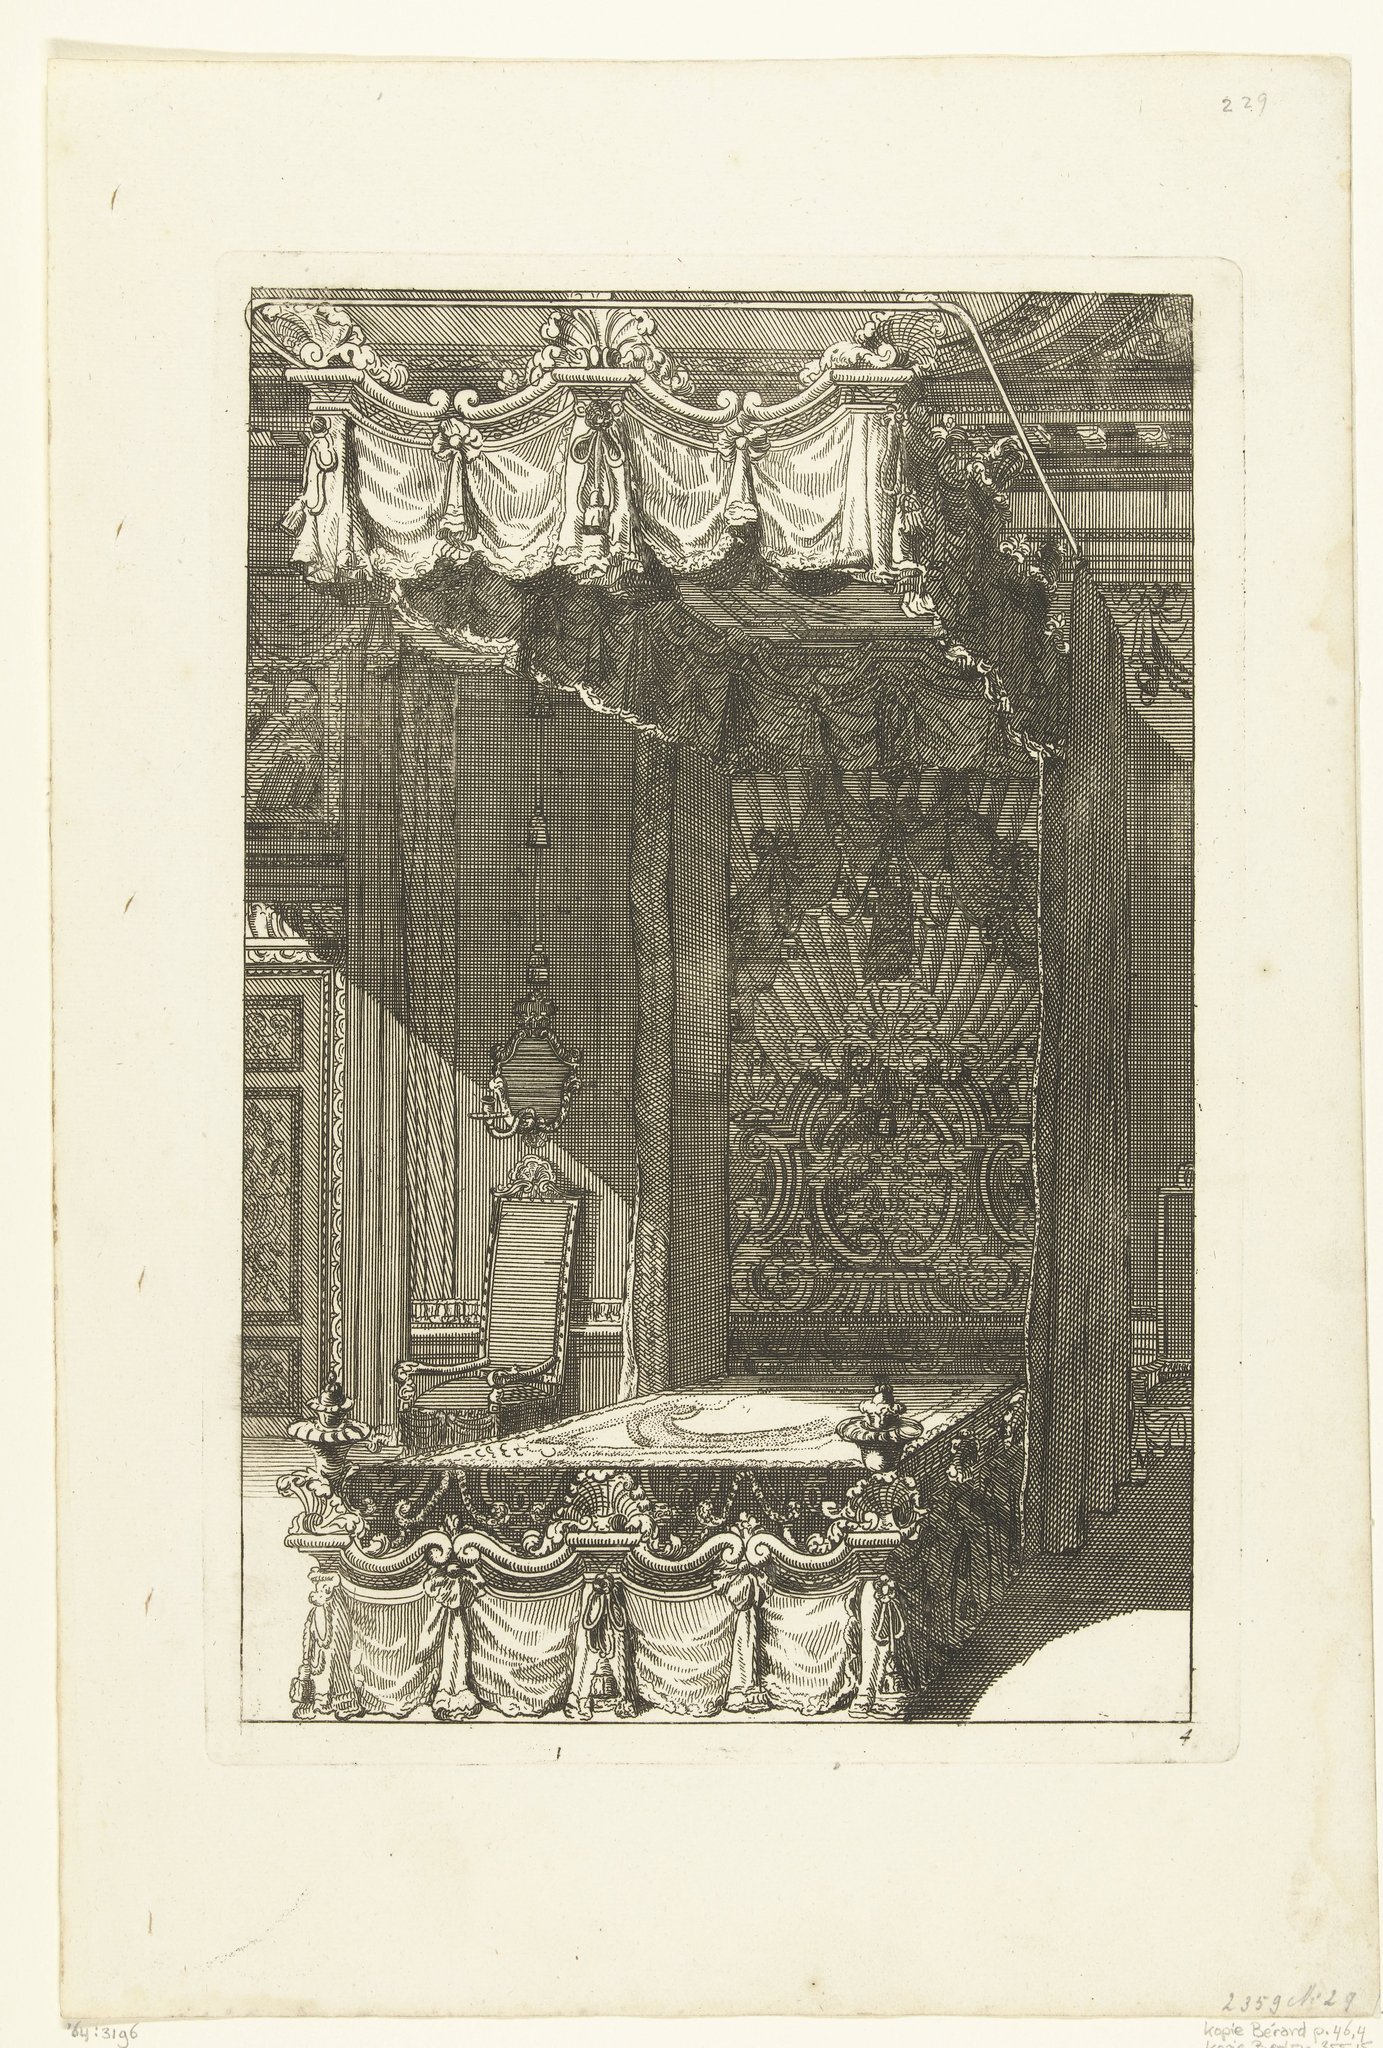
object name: print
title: Liure dappartement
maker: Anonymous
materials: paper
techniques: etching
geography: netherlands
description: Het bed heeft een rails rond het baldakijn waaraan teruggetrokken gordijnen hangen. Aan beide kanten staat een leunstoel tegen de muur. Tegenzijdige kopie naar blad uit de serie Second Liure Dappartements.